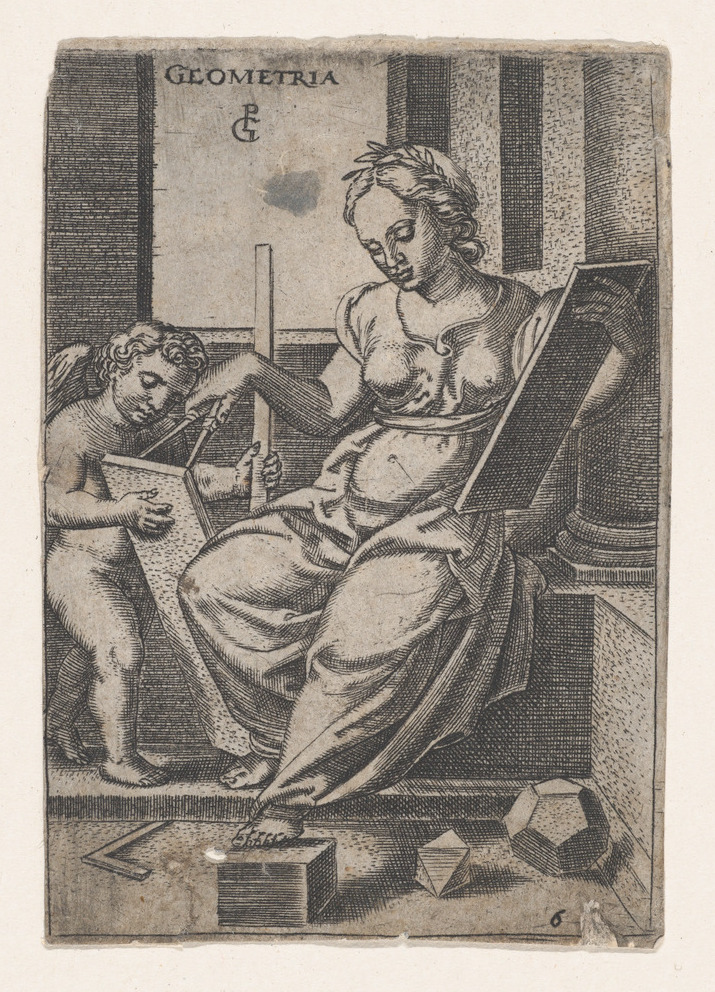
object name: print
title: Copy of Geometria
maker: georg pencz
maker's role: artist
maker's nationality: german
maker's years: 1500-1550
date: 1536-1600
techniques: engraving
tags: children,women,geometry